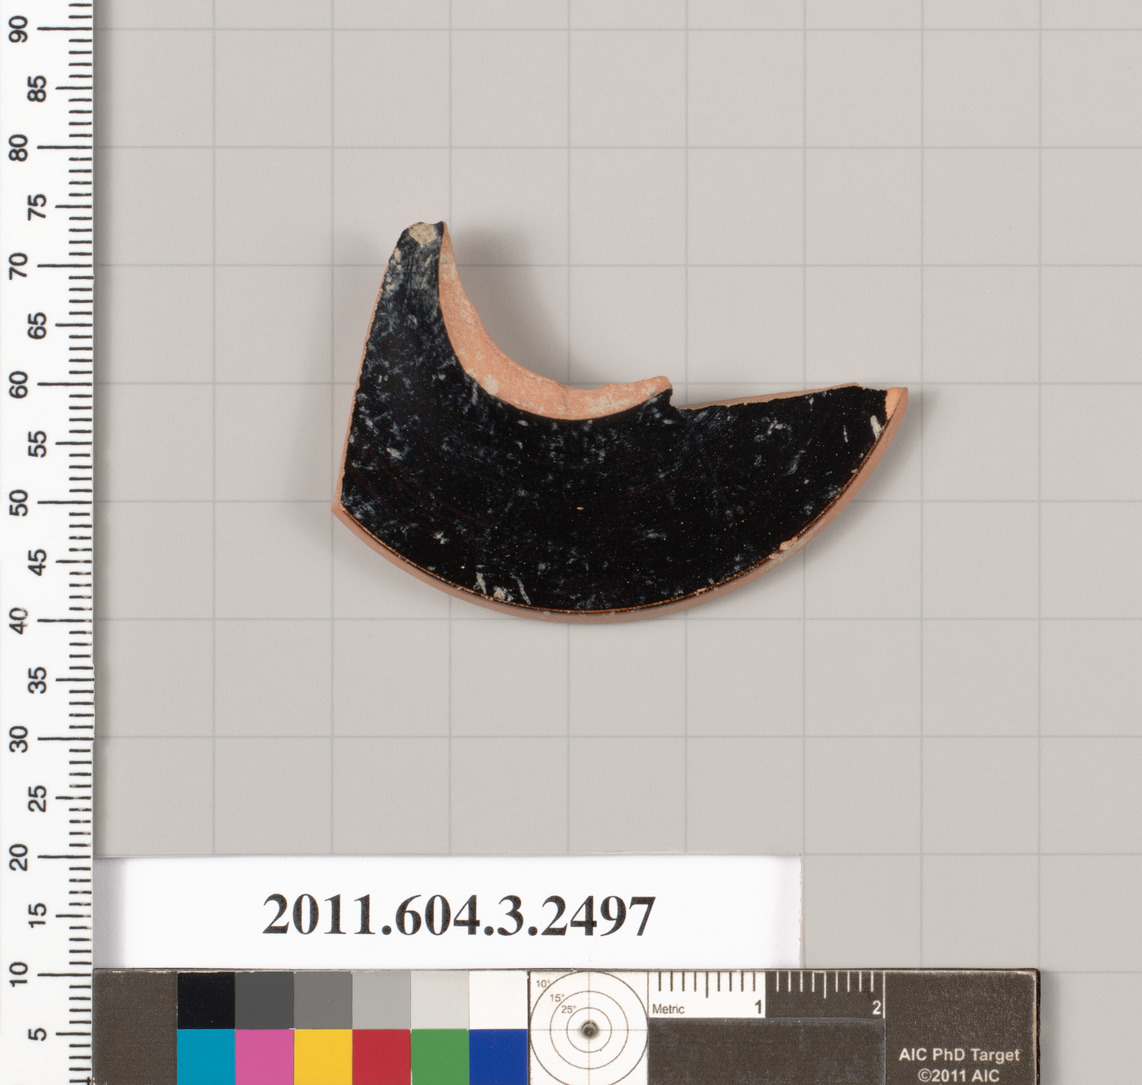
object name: kylix fragment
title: Terracotta fragment of a kylix (drinking cup)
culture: greek, attic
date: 600-401 BCE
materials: terracotta